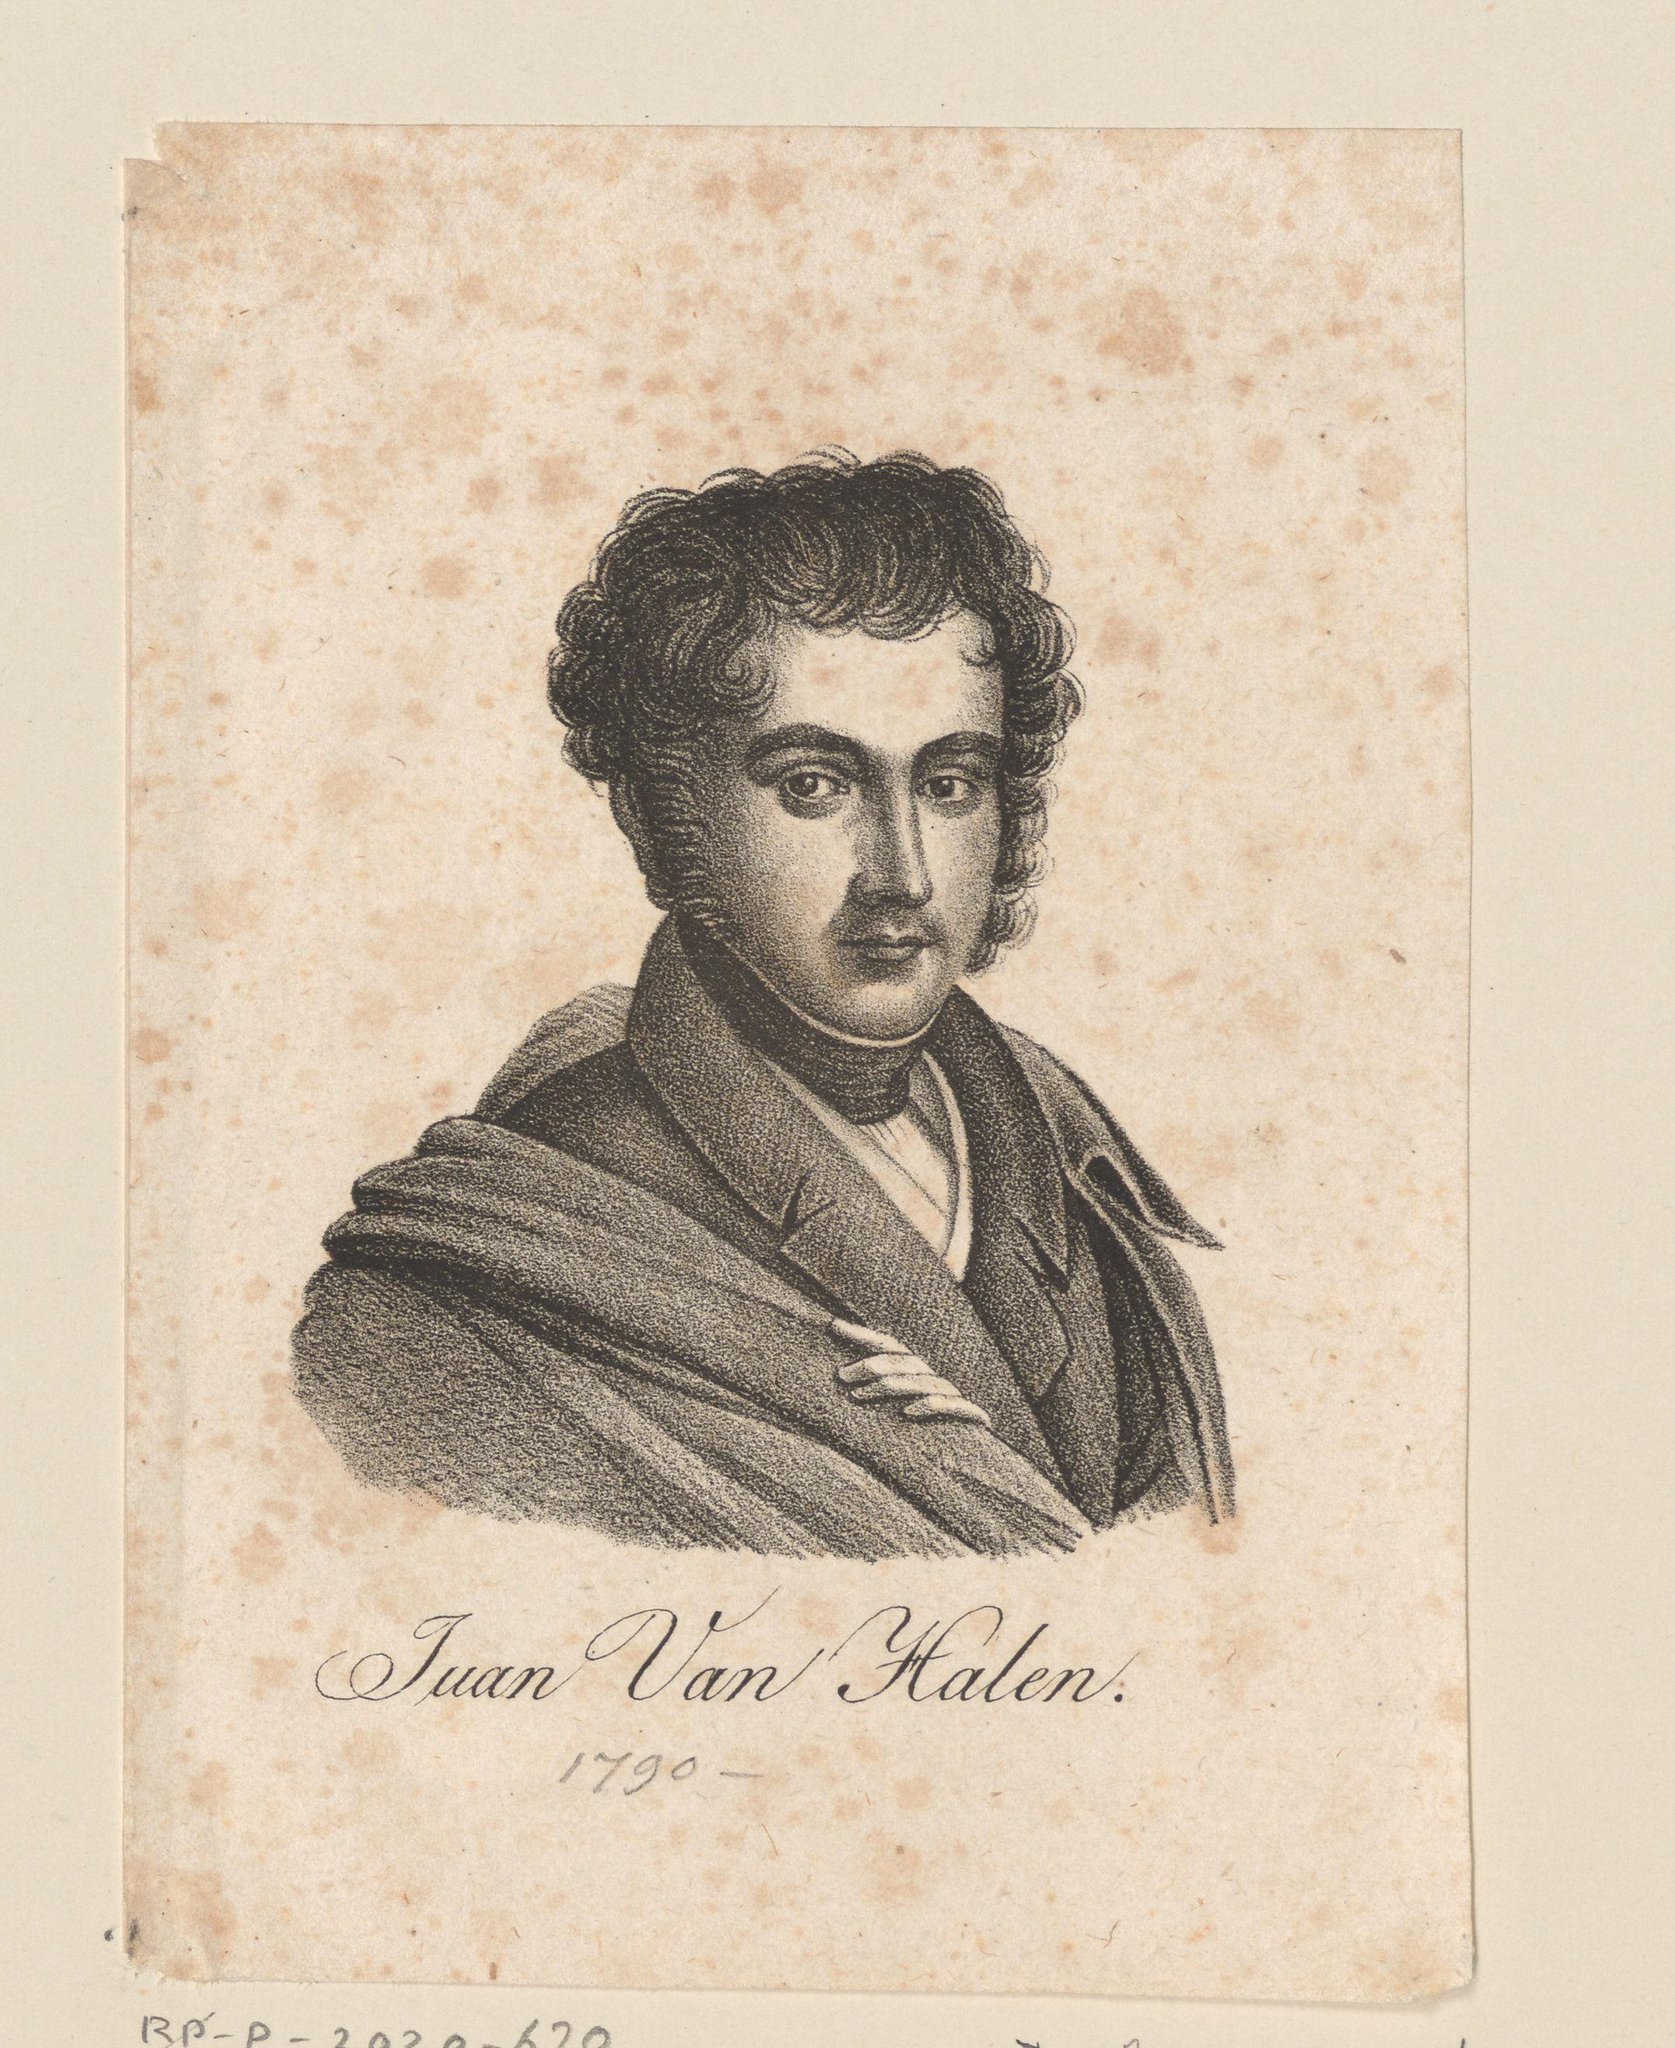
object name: print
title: Portret van Juan van Halen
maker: Anonymous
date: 1825-1874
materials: paper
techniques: lithograph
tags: historical persons